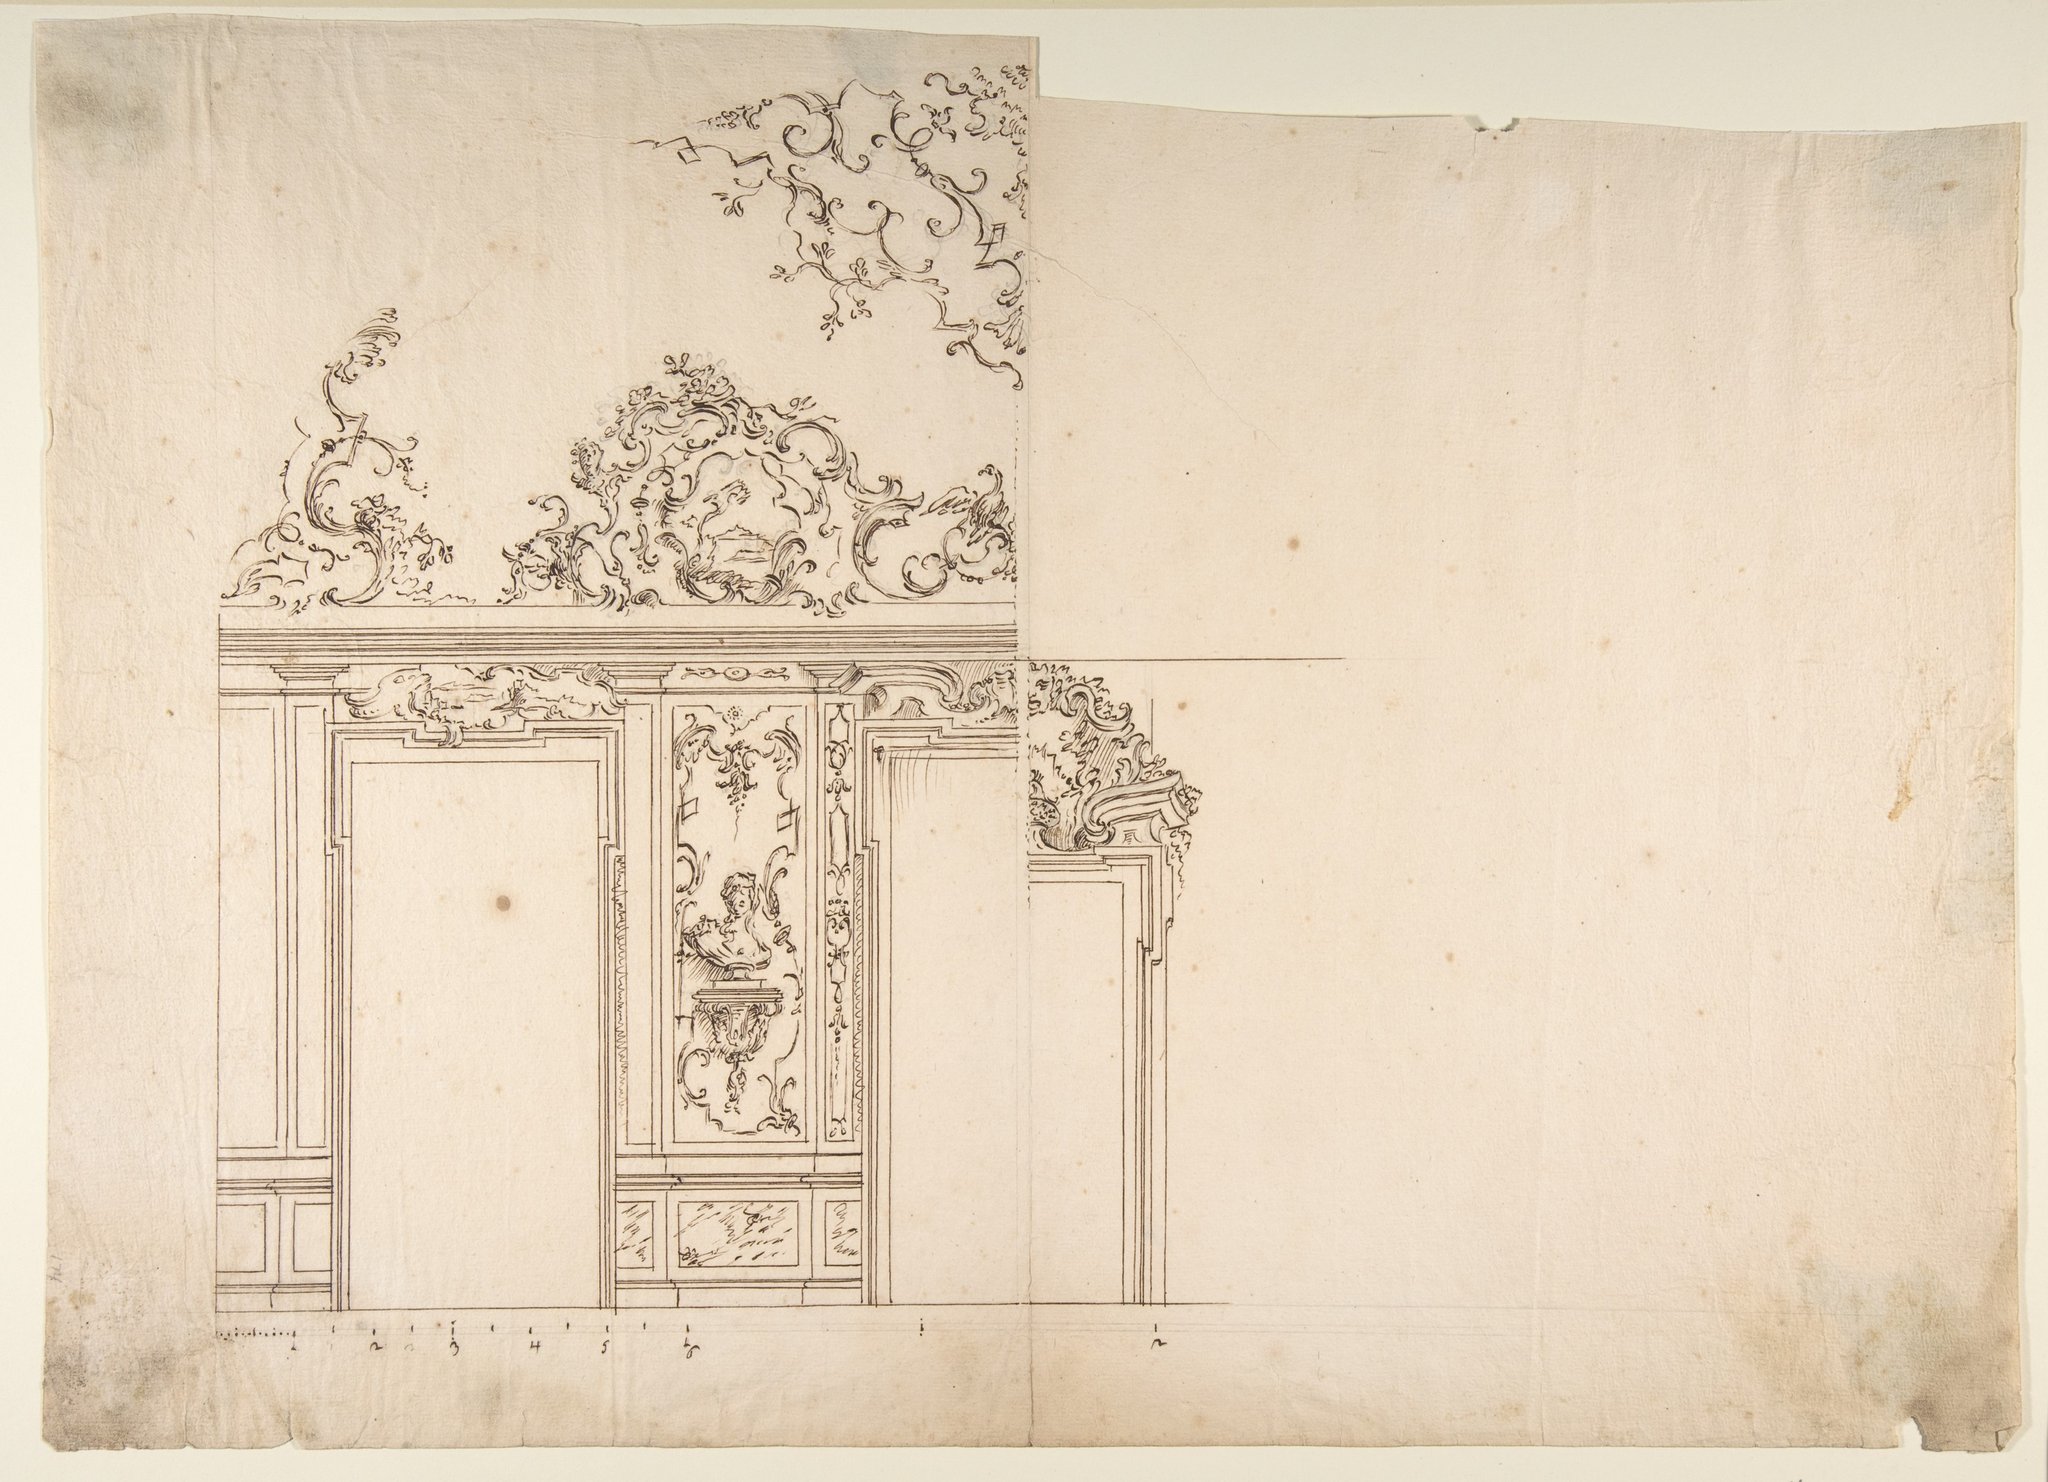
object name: drawing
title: Design for Door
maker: leonardo marini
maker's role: artist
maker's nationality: italian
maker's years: 1730-1797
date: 1701-1800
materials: graphite, ink, drawing material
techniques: pen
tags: architecture